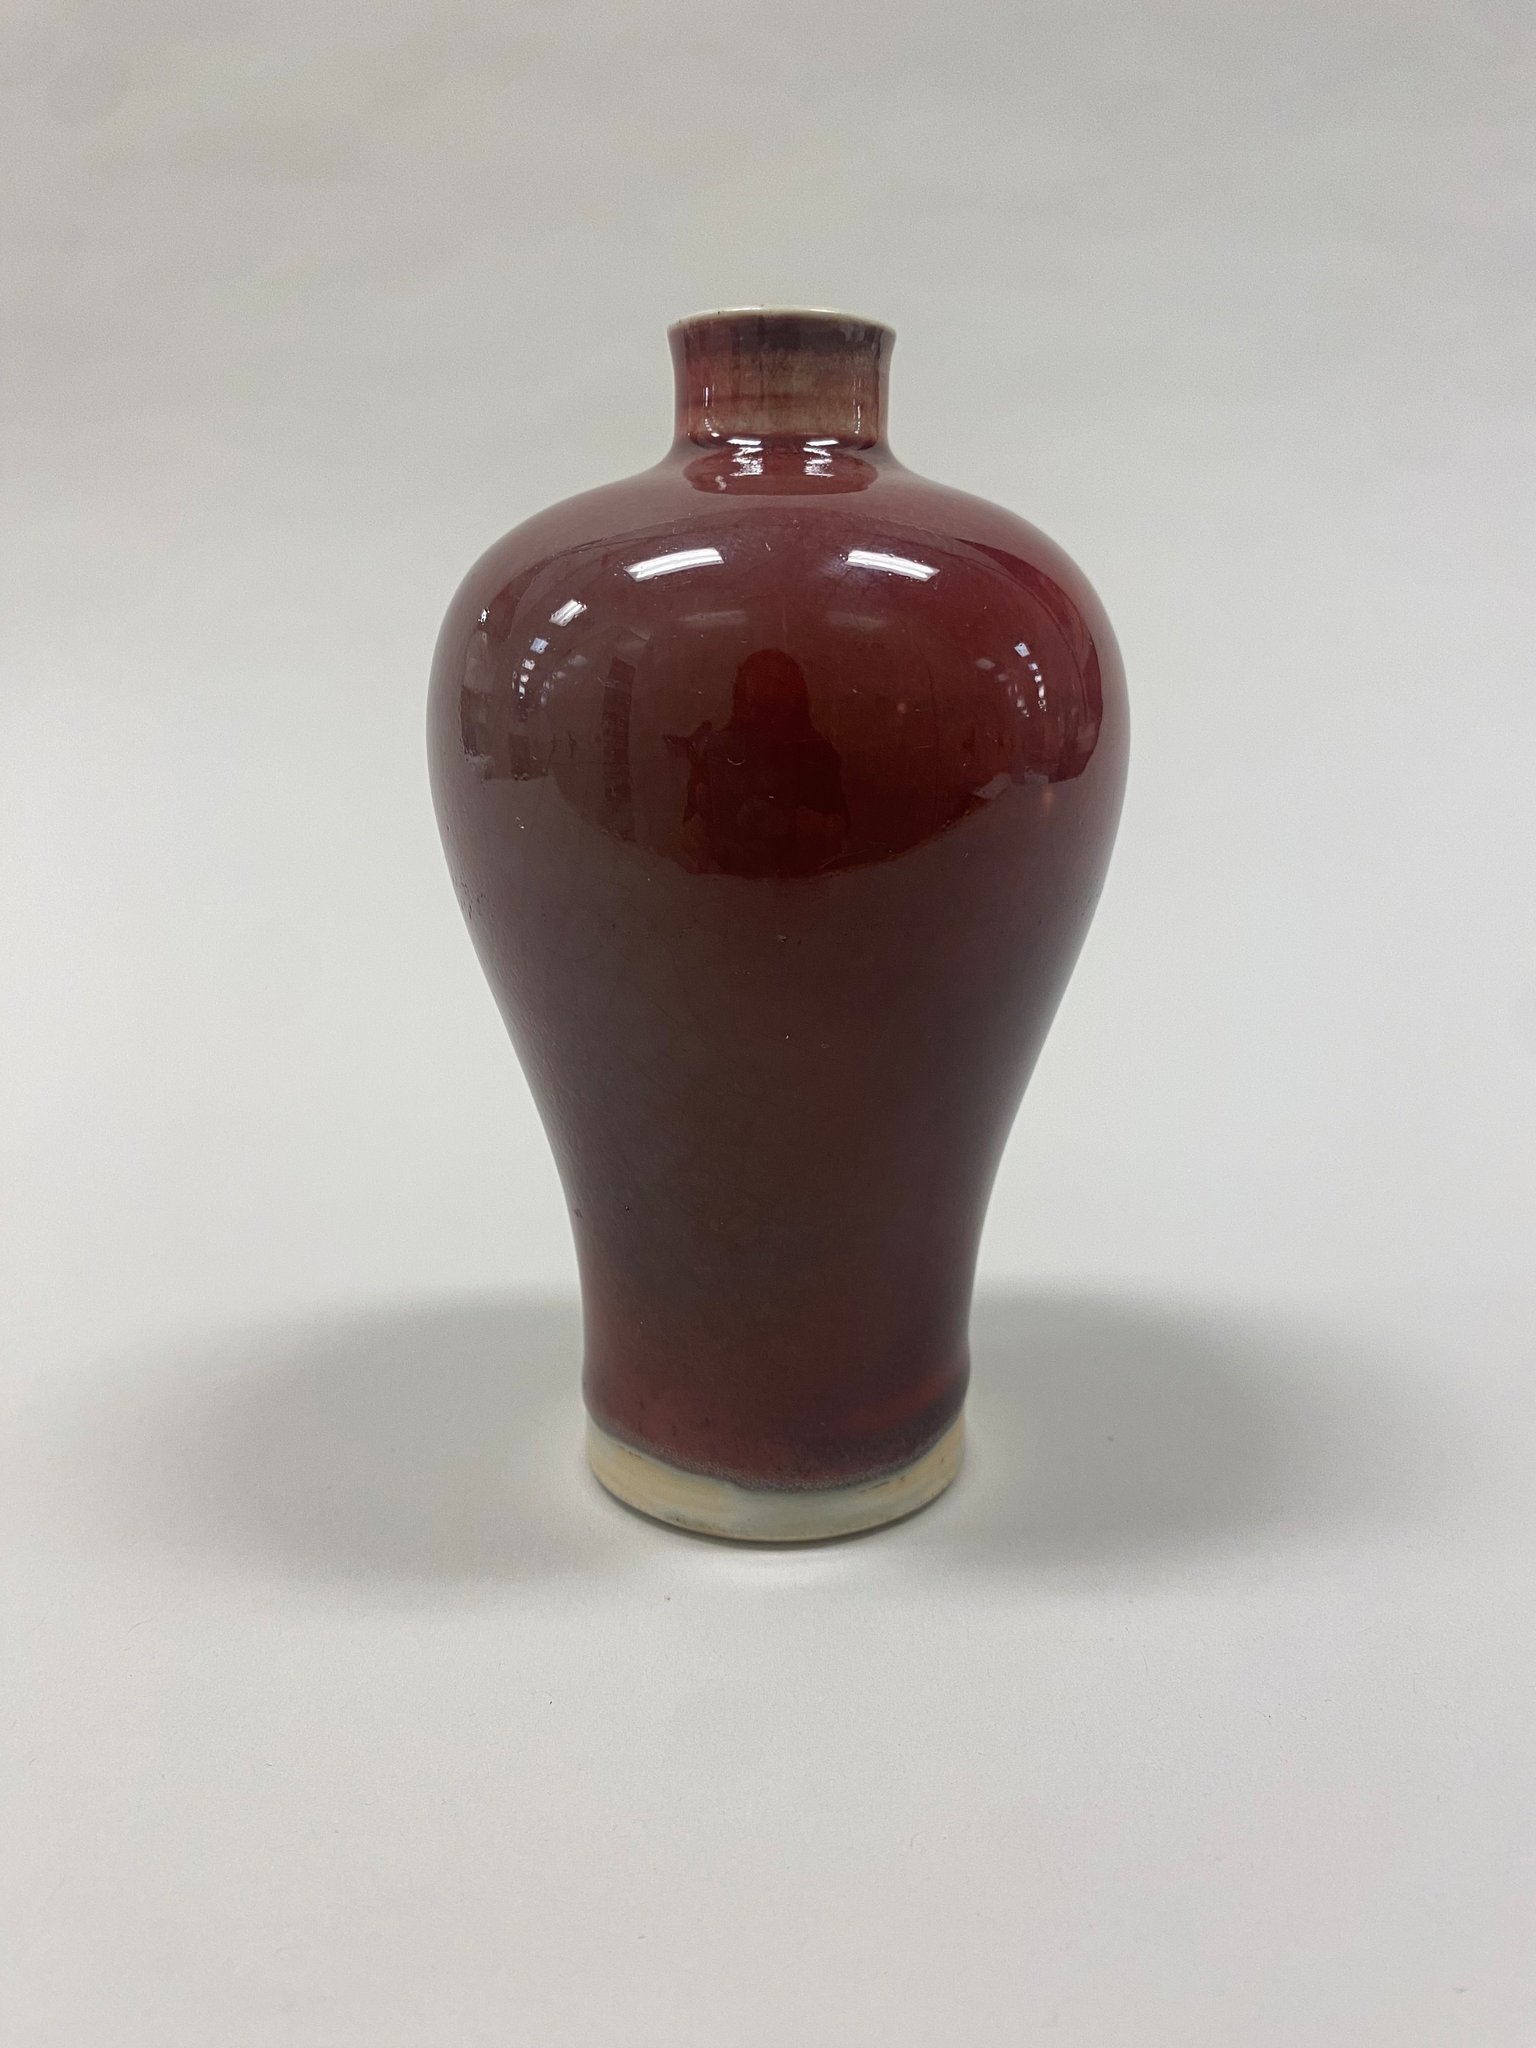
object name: vase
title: Meiping vase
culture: chinese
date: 1701-1800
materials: copper, glaze, porcelain